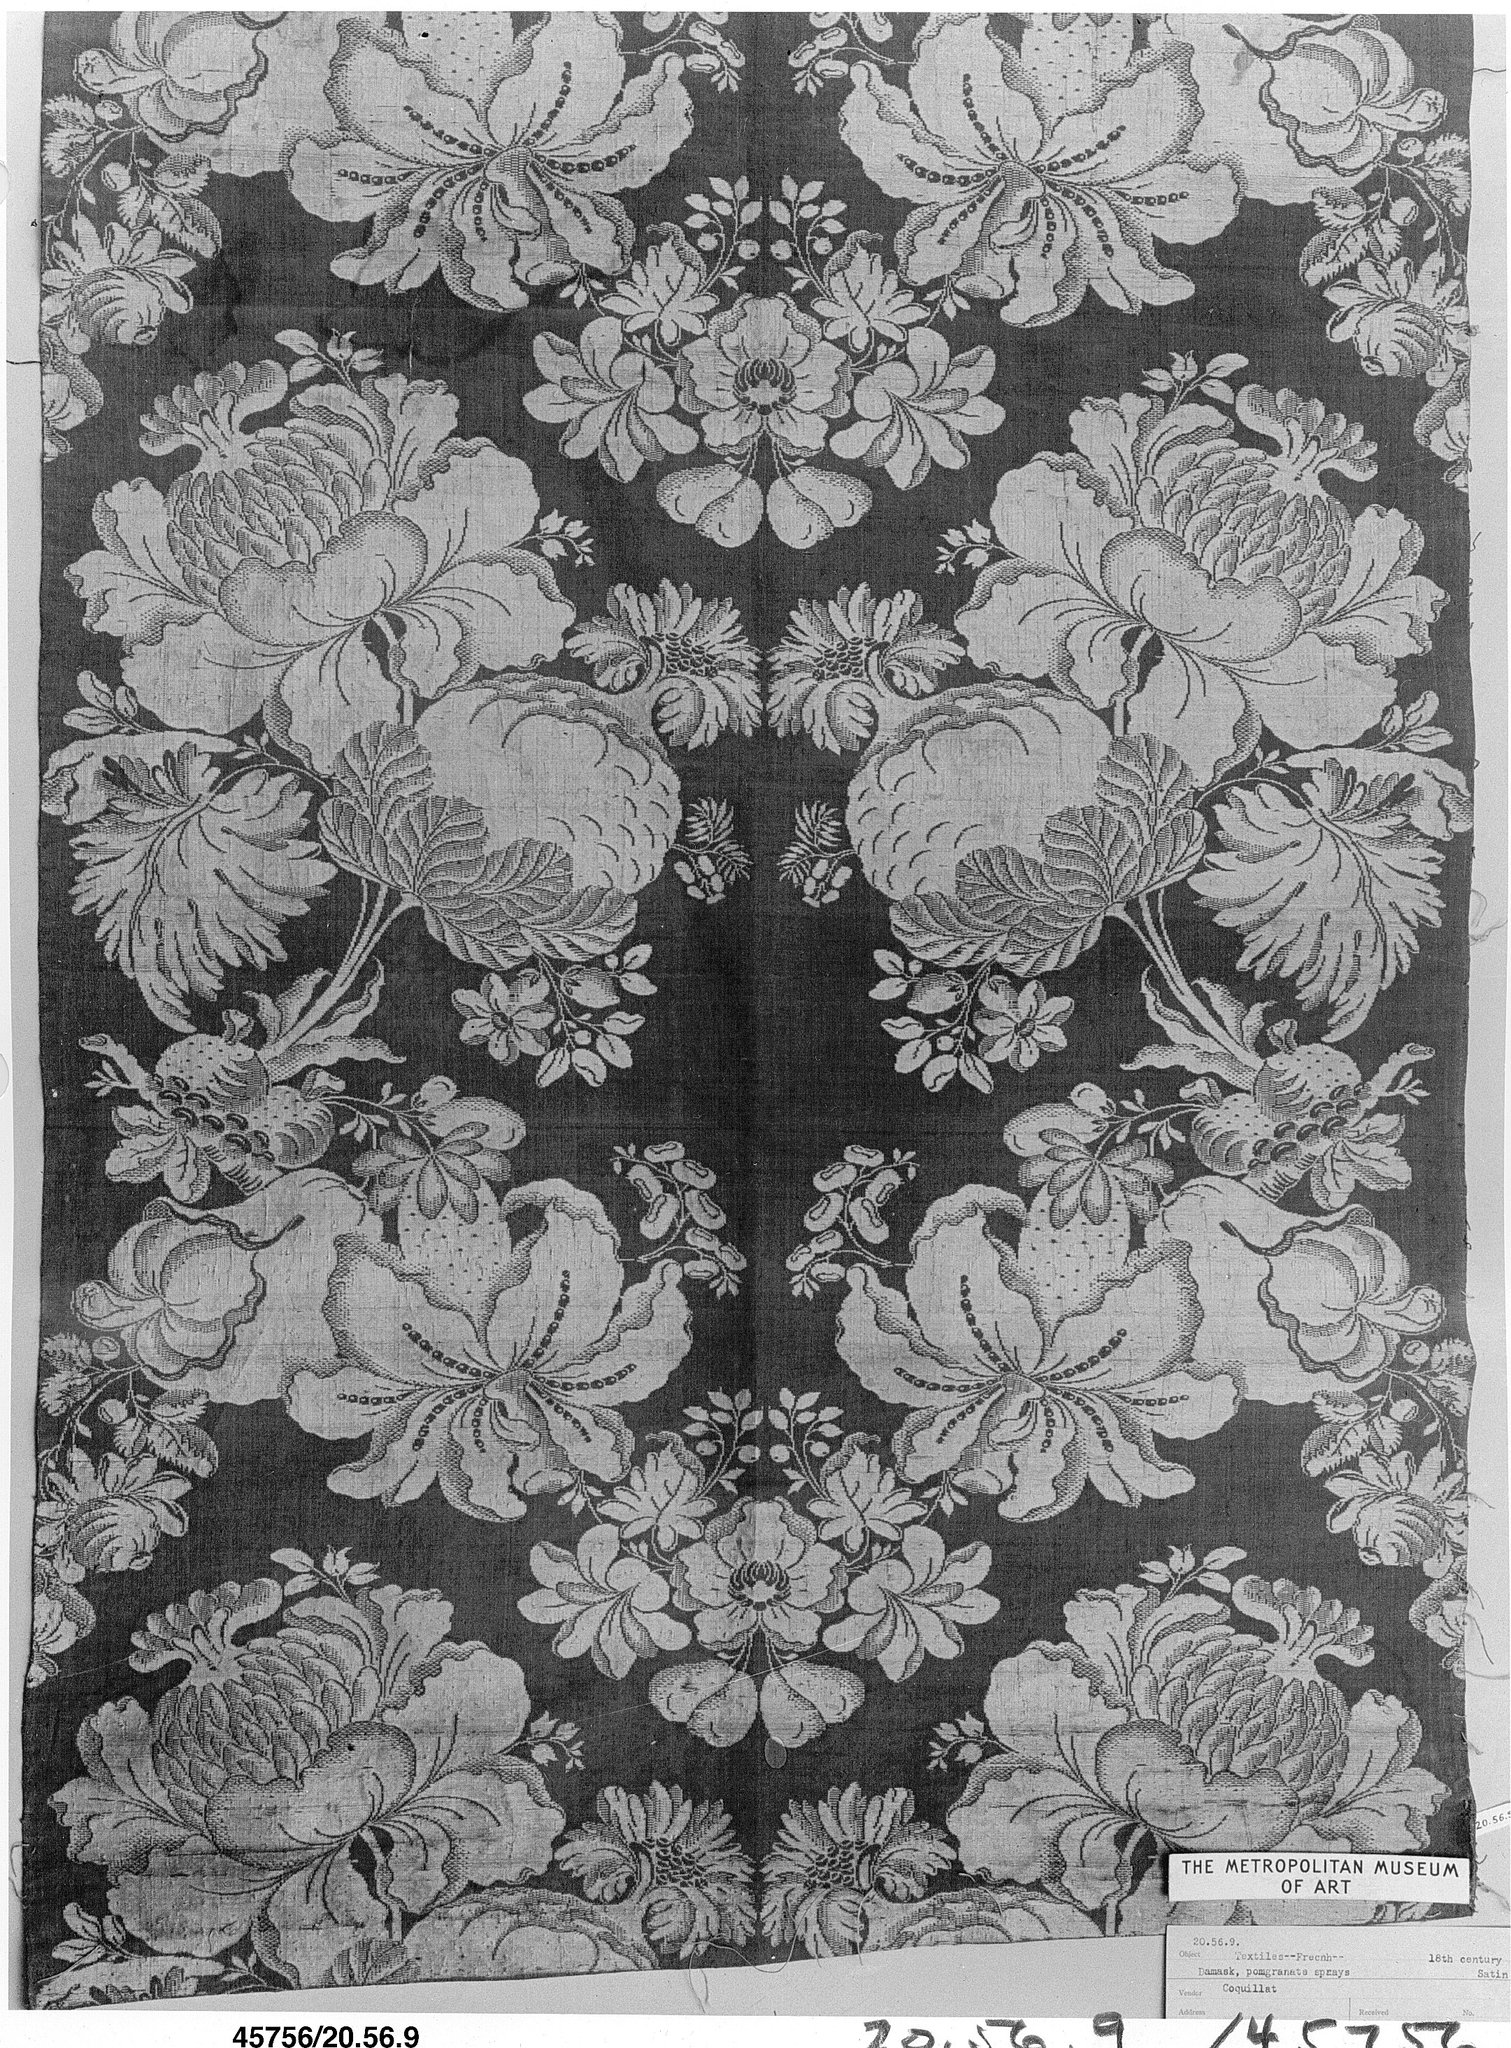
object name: piece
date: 1735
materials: silk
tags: flowers,leaves